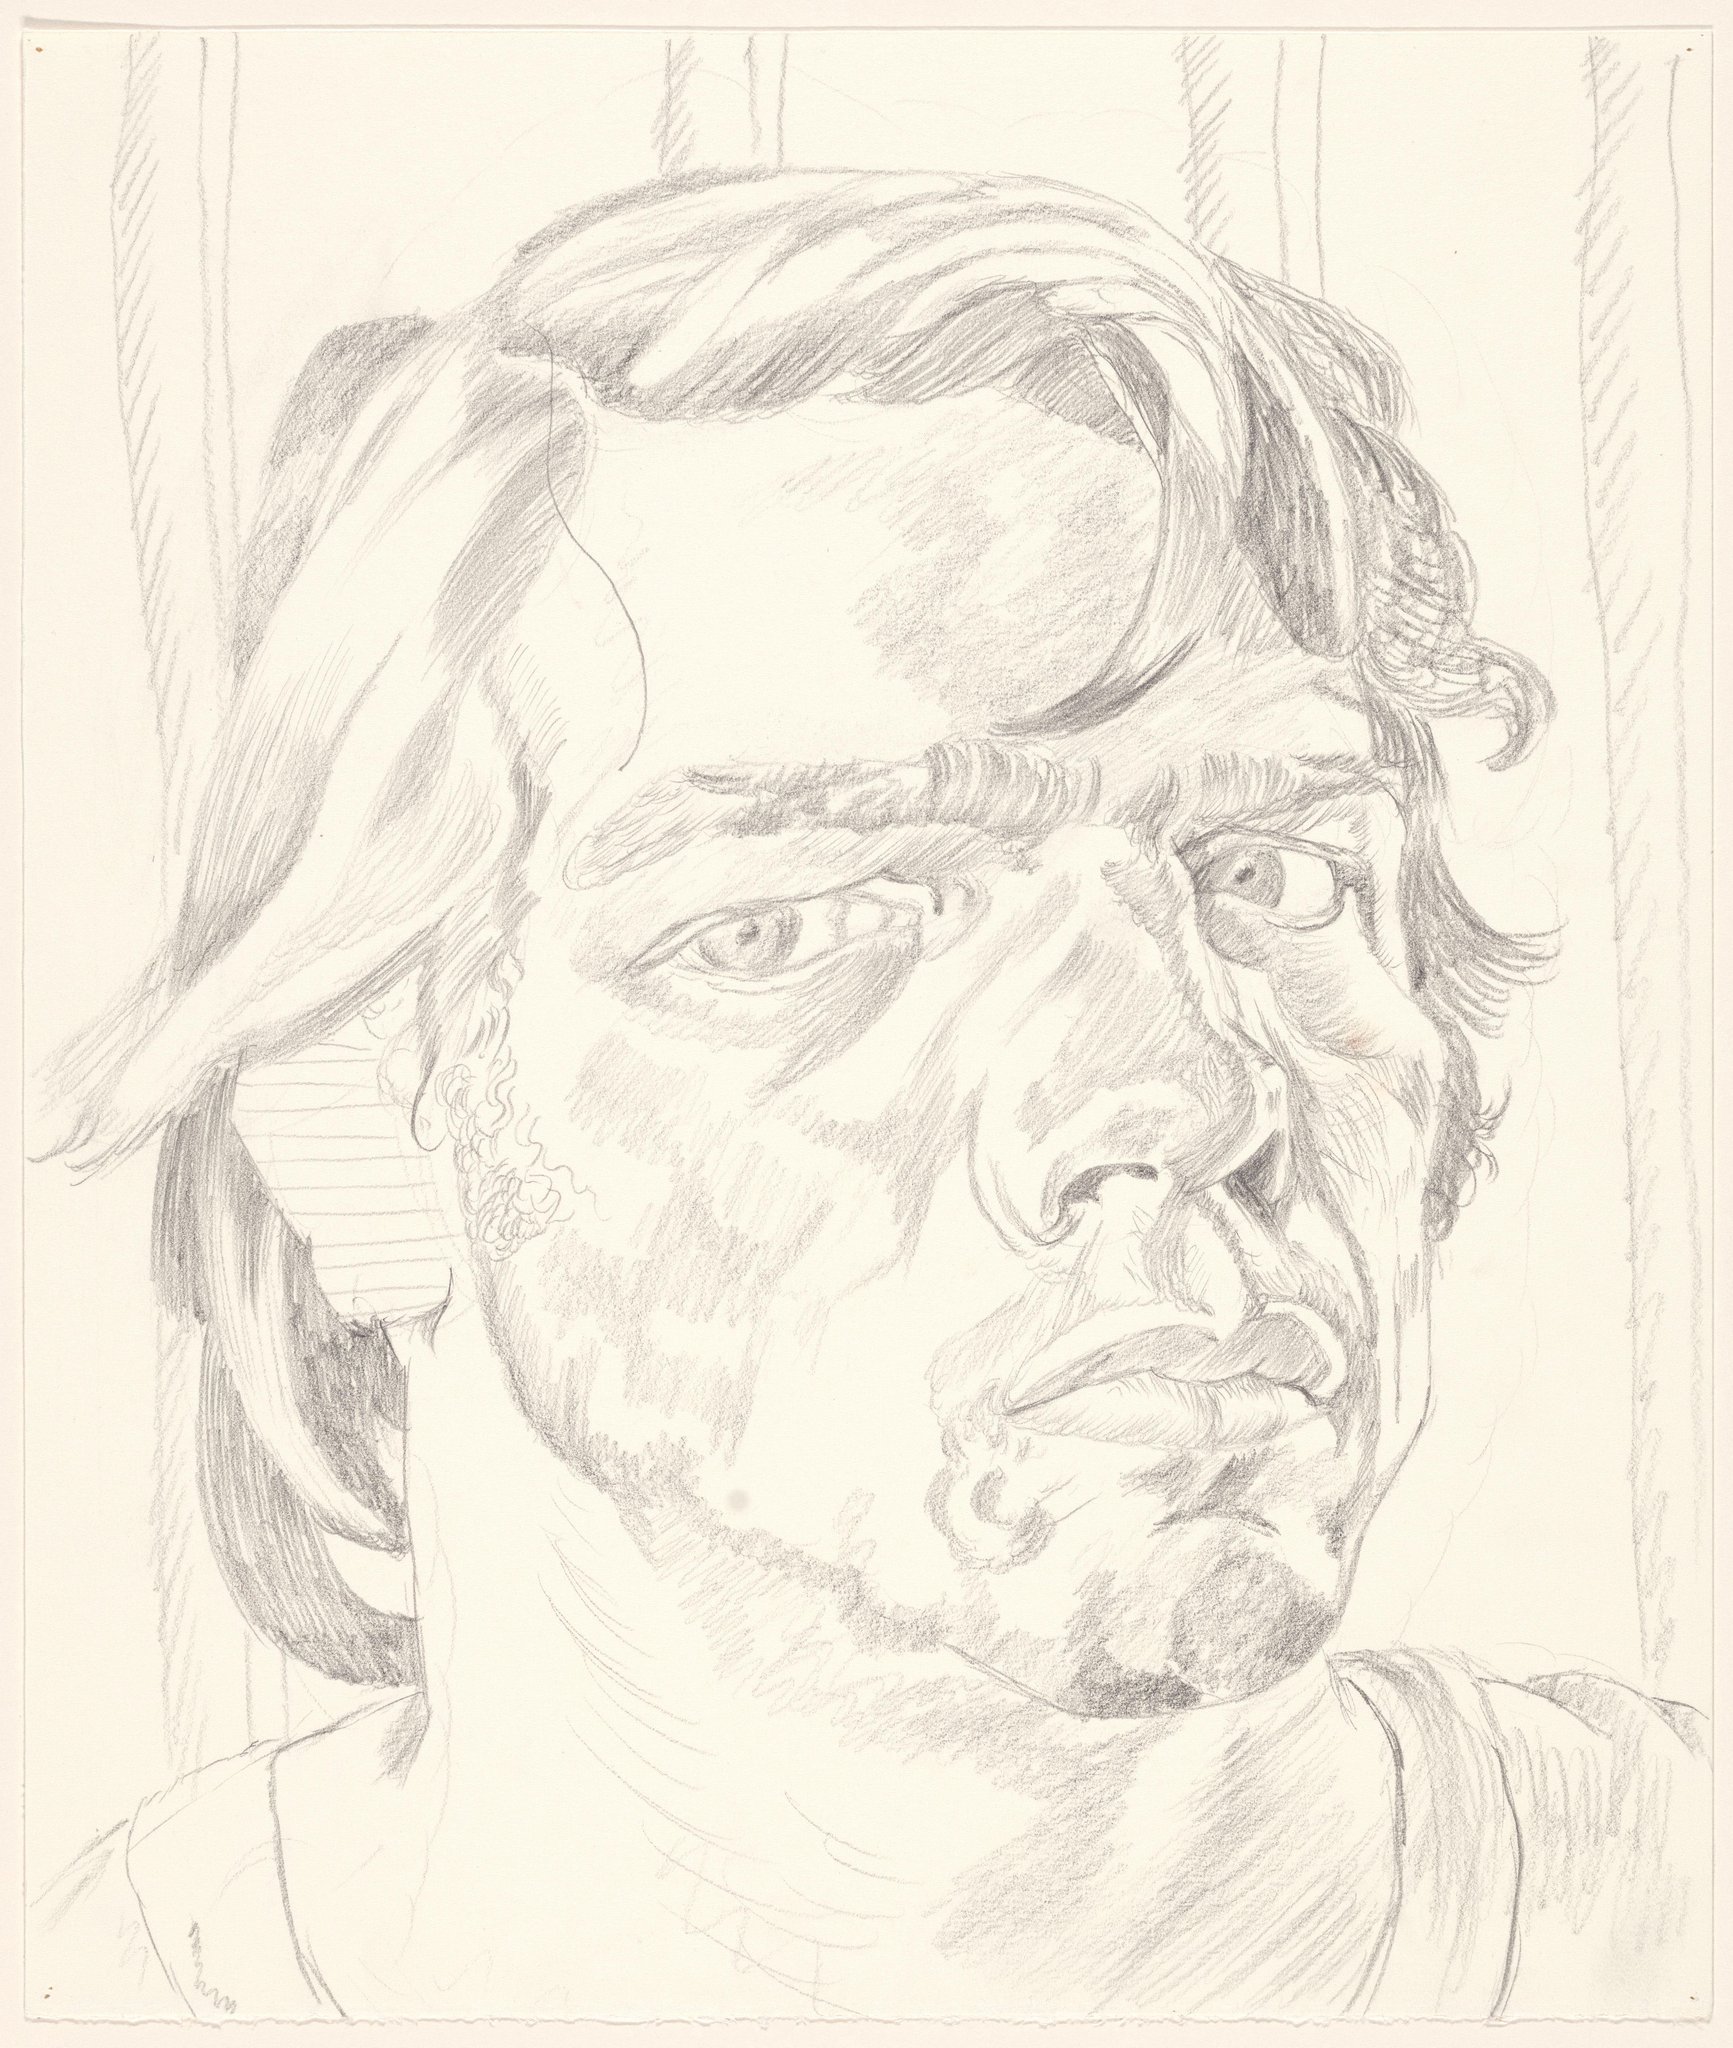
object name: drawing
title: Zelfportret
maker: philip akkerman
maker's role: draughtsman, painter, sculptor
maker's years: 1957-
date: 1991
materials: paper, pencil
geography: netherlands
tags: painter, draughtsman, sculptor, philip akkerman, historical persons, portrait, self-portrait of painter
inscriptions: collector's mark: Lugt 2228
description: ¾ En face weergegeven zelfportret met kort haar en kraagloos shirt. Tekening nr. 35.